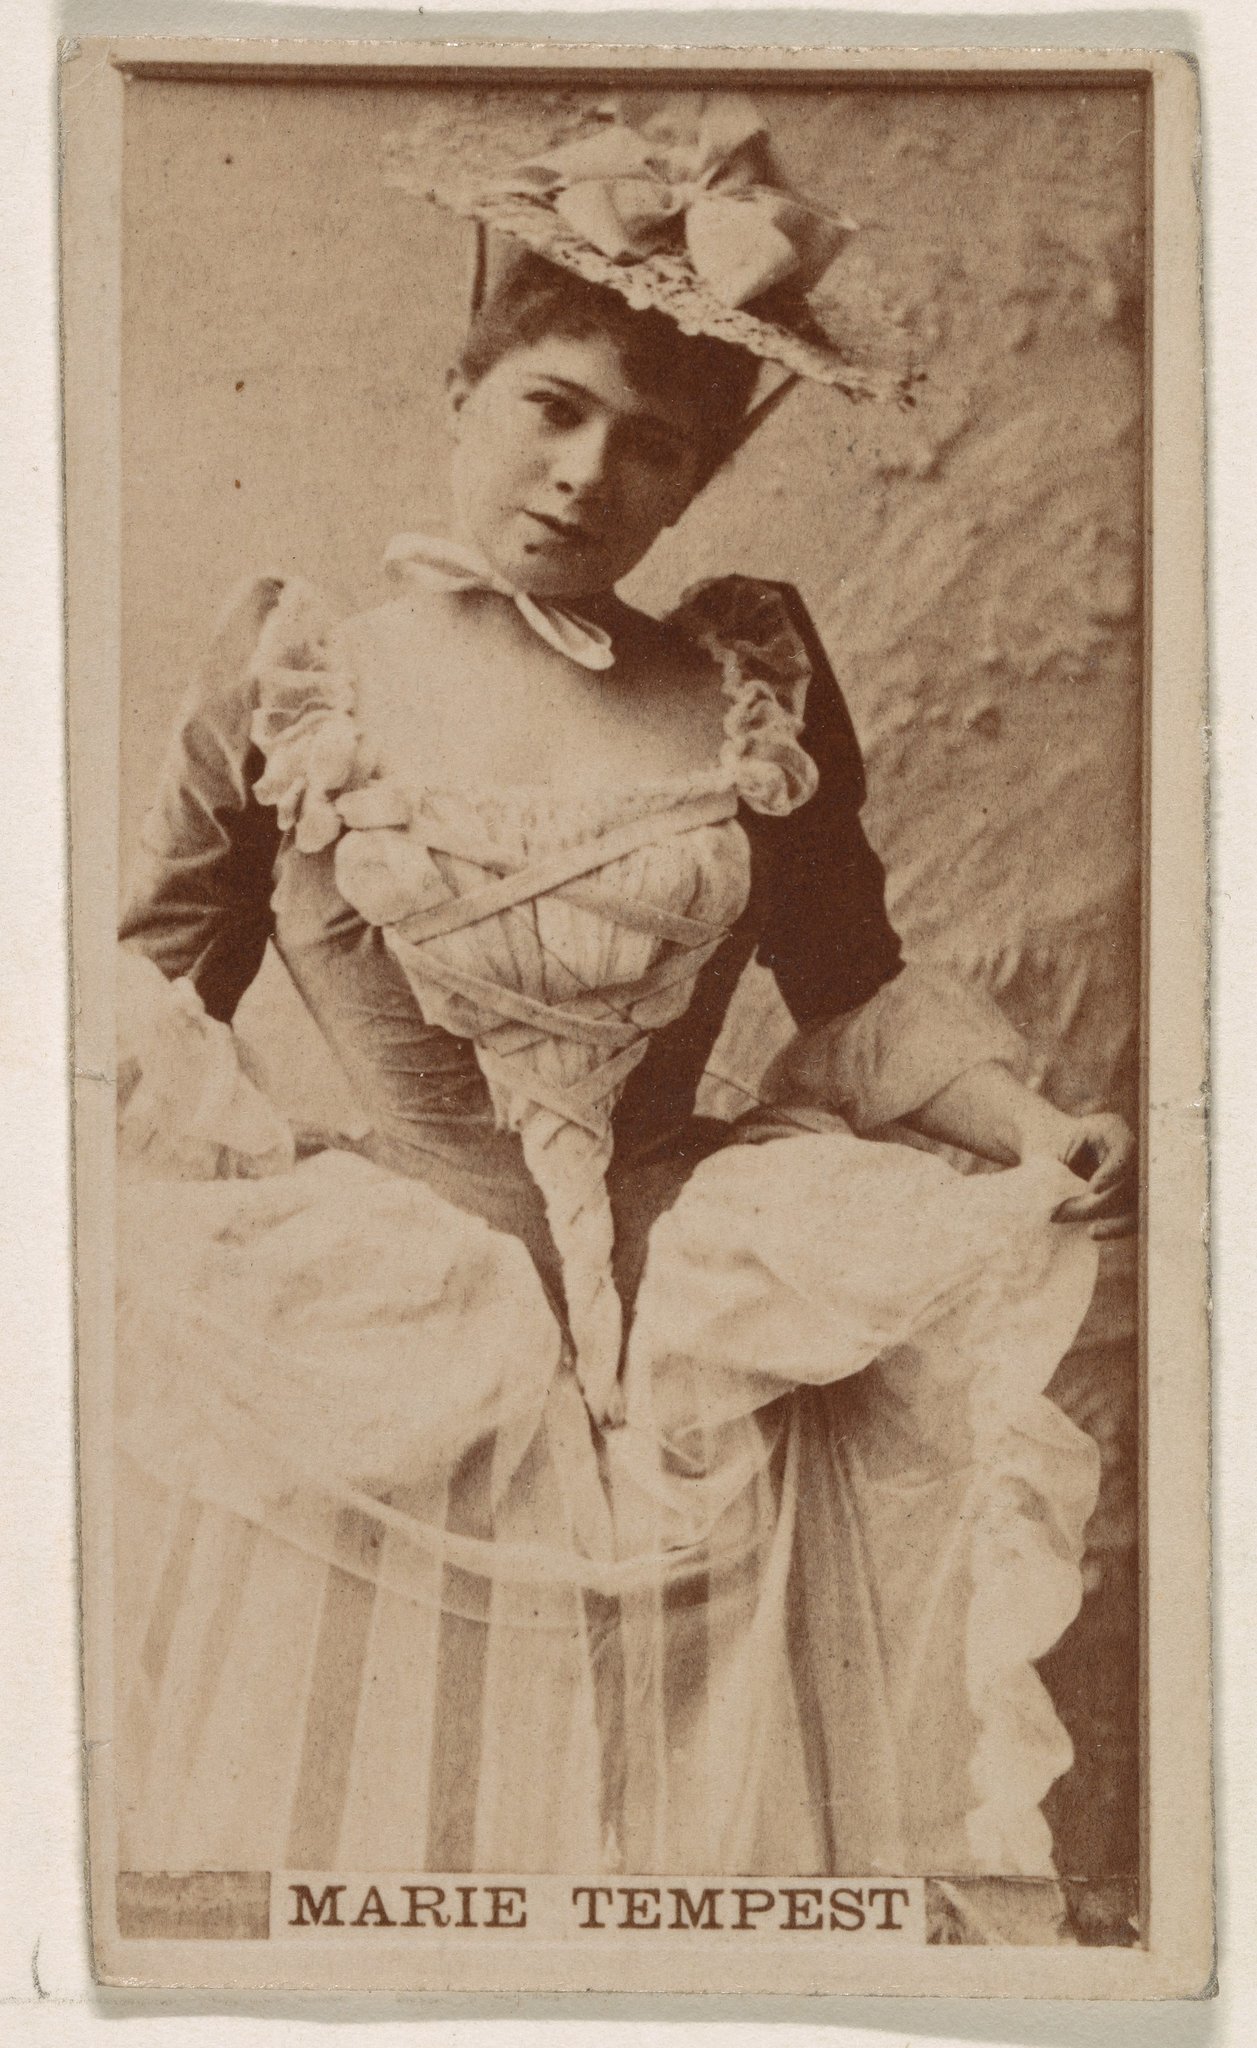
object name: photograph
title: Marie Tempest, from the Actresses series (N245) issued by Kinney Brothers to promote Sweet Caporal Cigarettes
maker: kinney brothers tobacco company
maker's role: publisher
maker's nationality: american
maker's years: 1869-2011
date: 1890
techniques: albumen silver print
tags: portraits,women,actresses